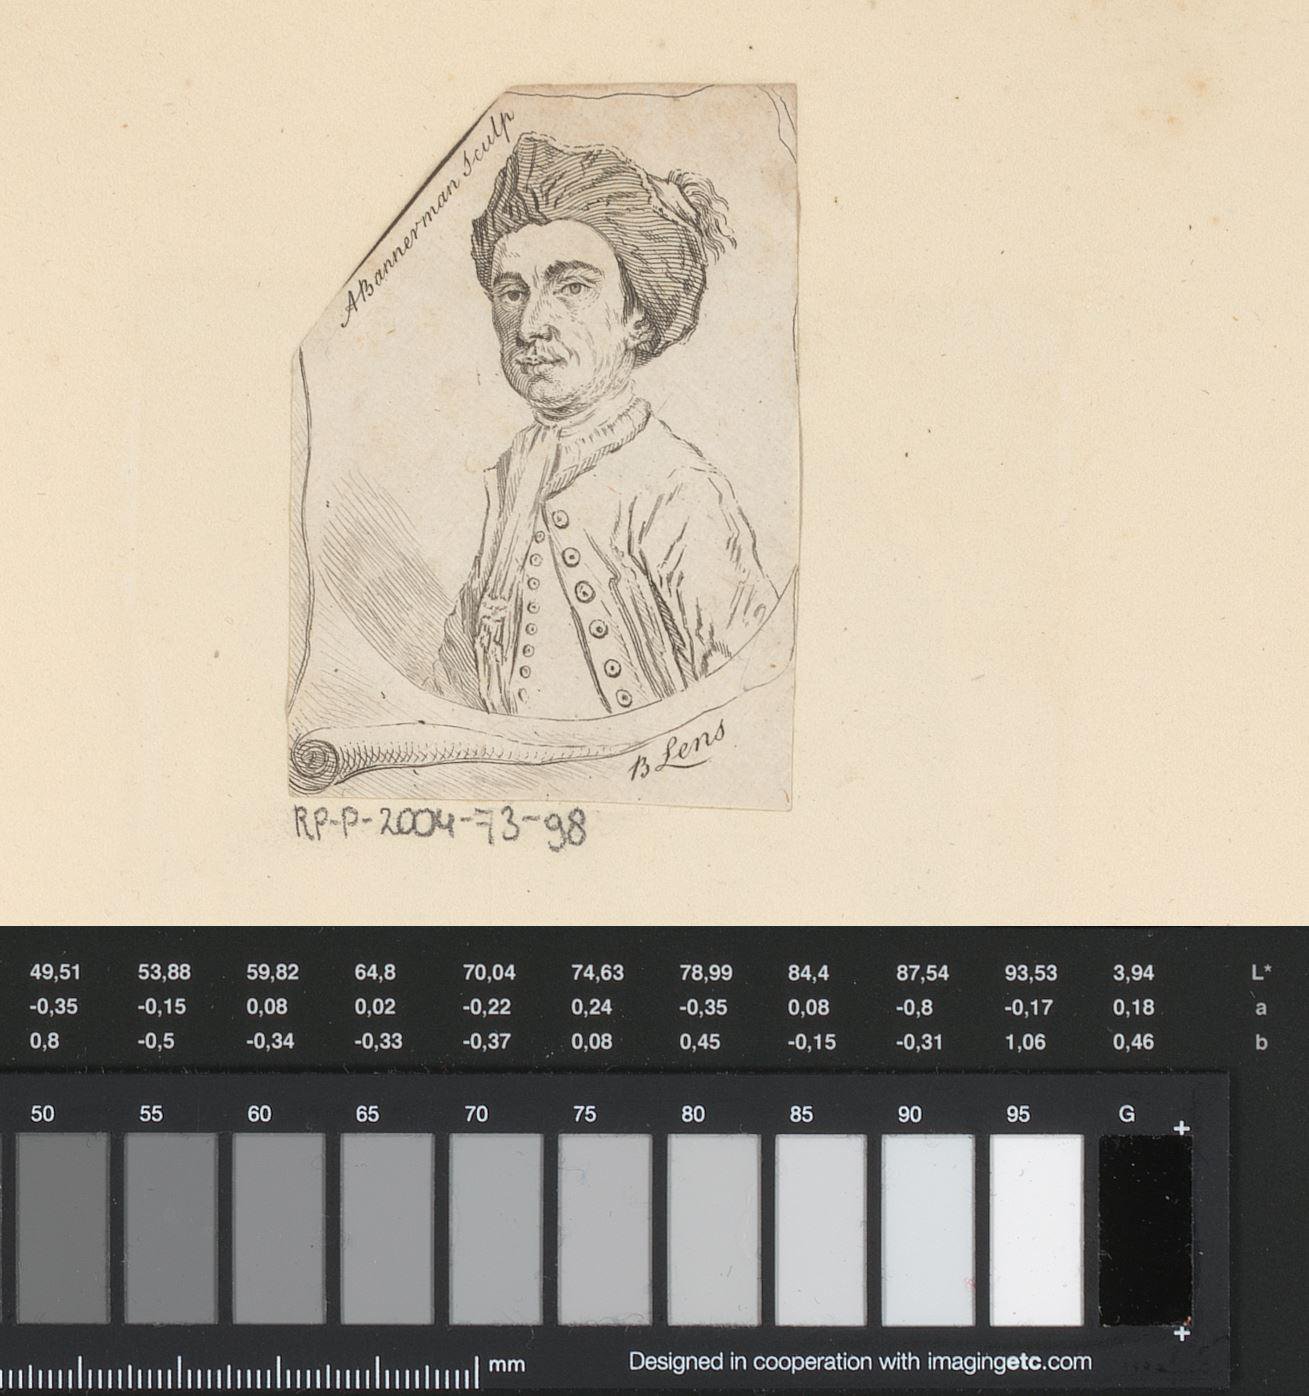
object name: book illustration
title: Portret van Bernard Lens (III)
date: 1762-1789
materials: paper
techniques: engraving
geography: london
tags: london, print maker, artist, historical persons, portrait, self-portrait of painter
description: Prent uit: Walpole, Horace. Anecdotes of painting in England with some account of the principal artists and incidental notes on other arts collected by the late Mr. George Vertue and now digested and published from his original Mss. by Horace Walpole. 4 dln. Londen: Horace Walpole, [1762-1789], dl. 4, p. 2. De samensteller heeft deze prent in het album geplakt als illustratie bij: Pilkington, Matthew en Johann Heinrich Füssli. A dictionary of painters, from the revival of the art to the present period. 4 dln. Londen: John Crowder, 1805, dl. 2, p. 295.